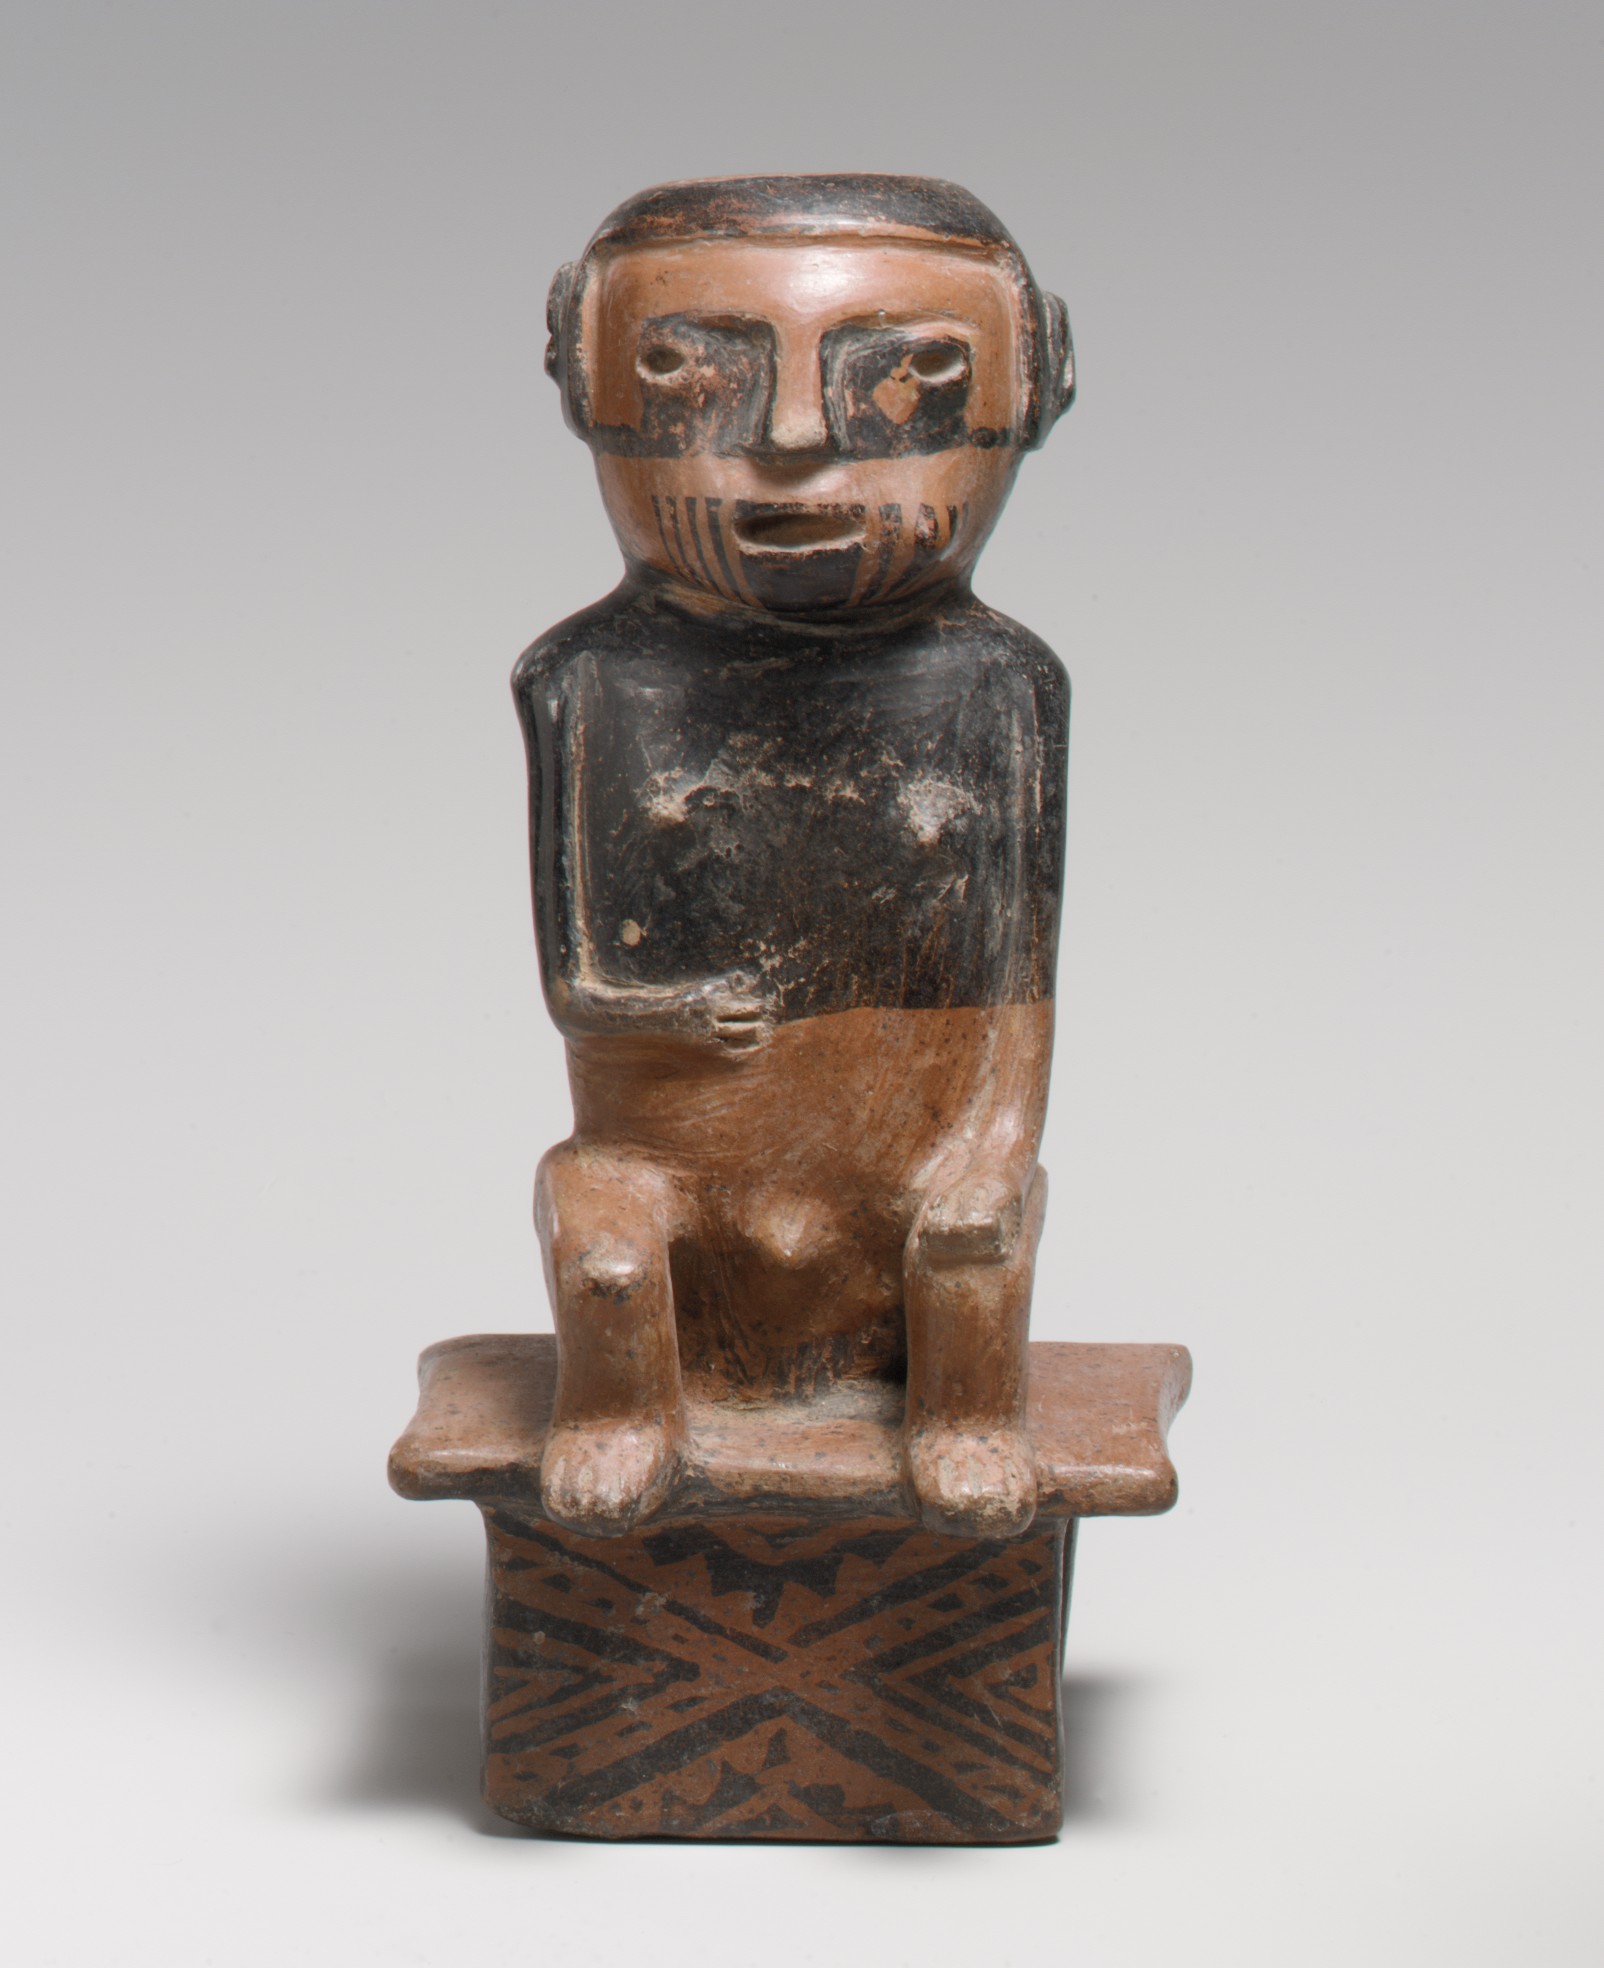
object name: male figure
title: Coca chewer on bench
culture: capulí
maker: capulí artist(s)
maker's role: artist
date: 800-1500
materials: ceramic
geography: ecuador